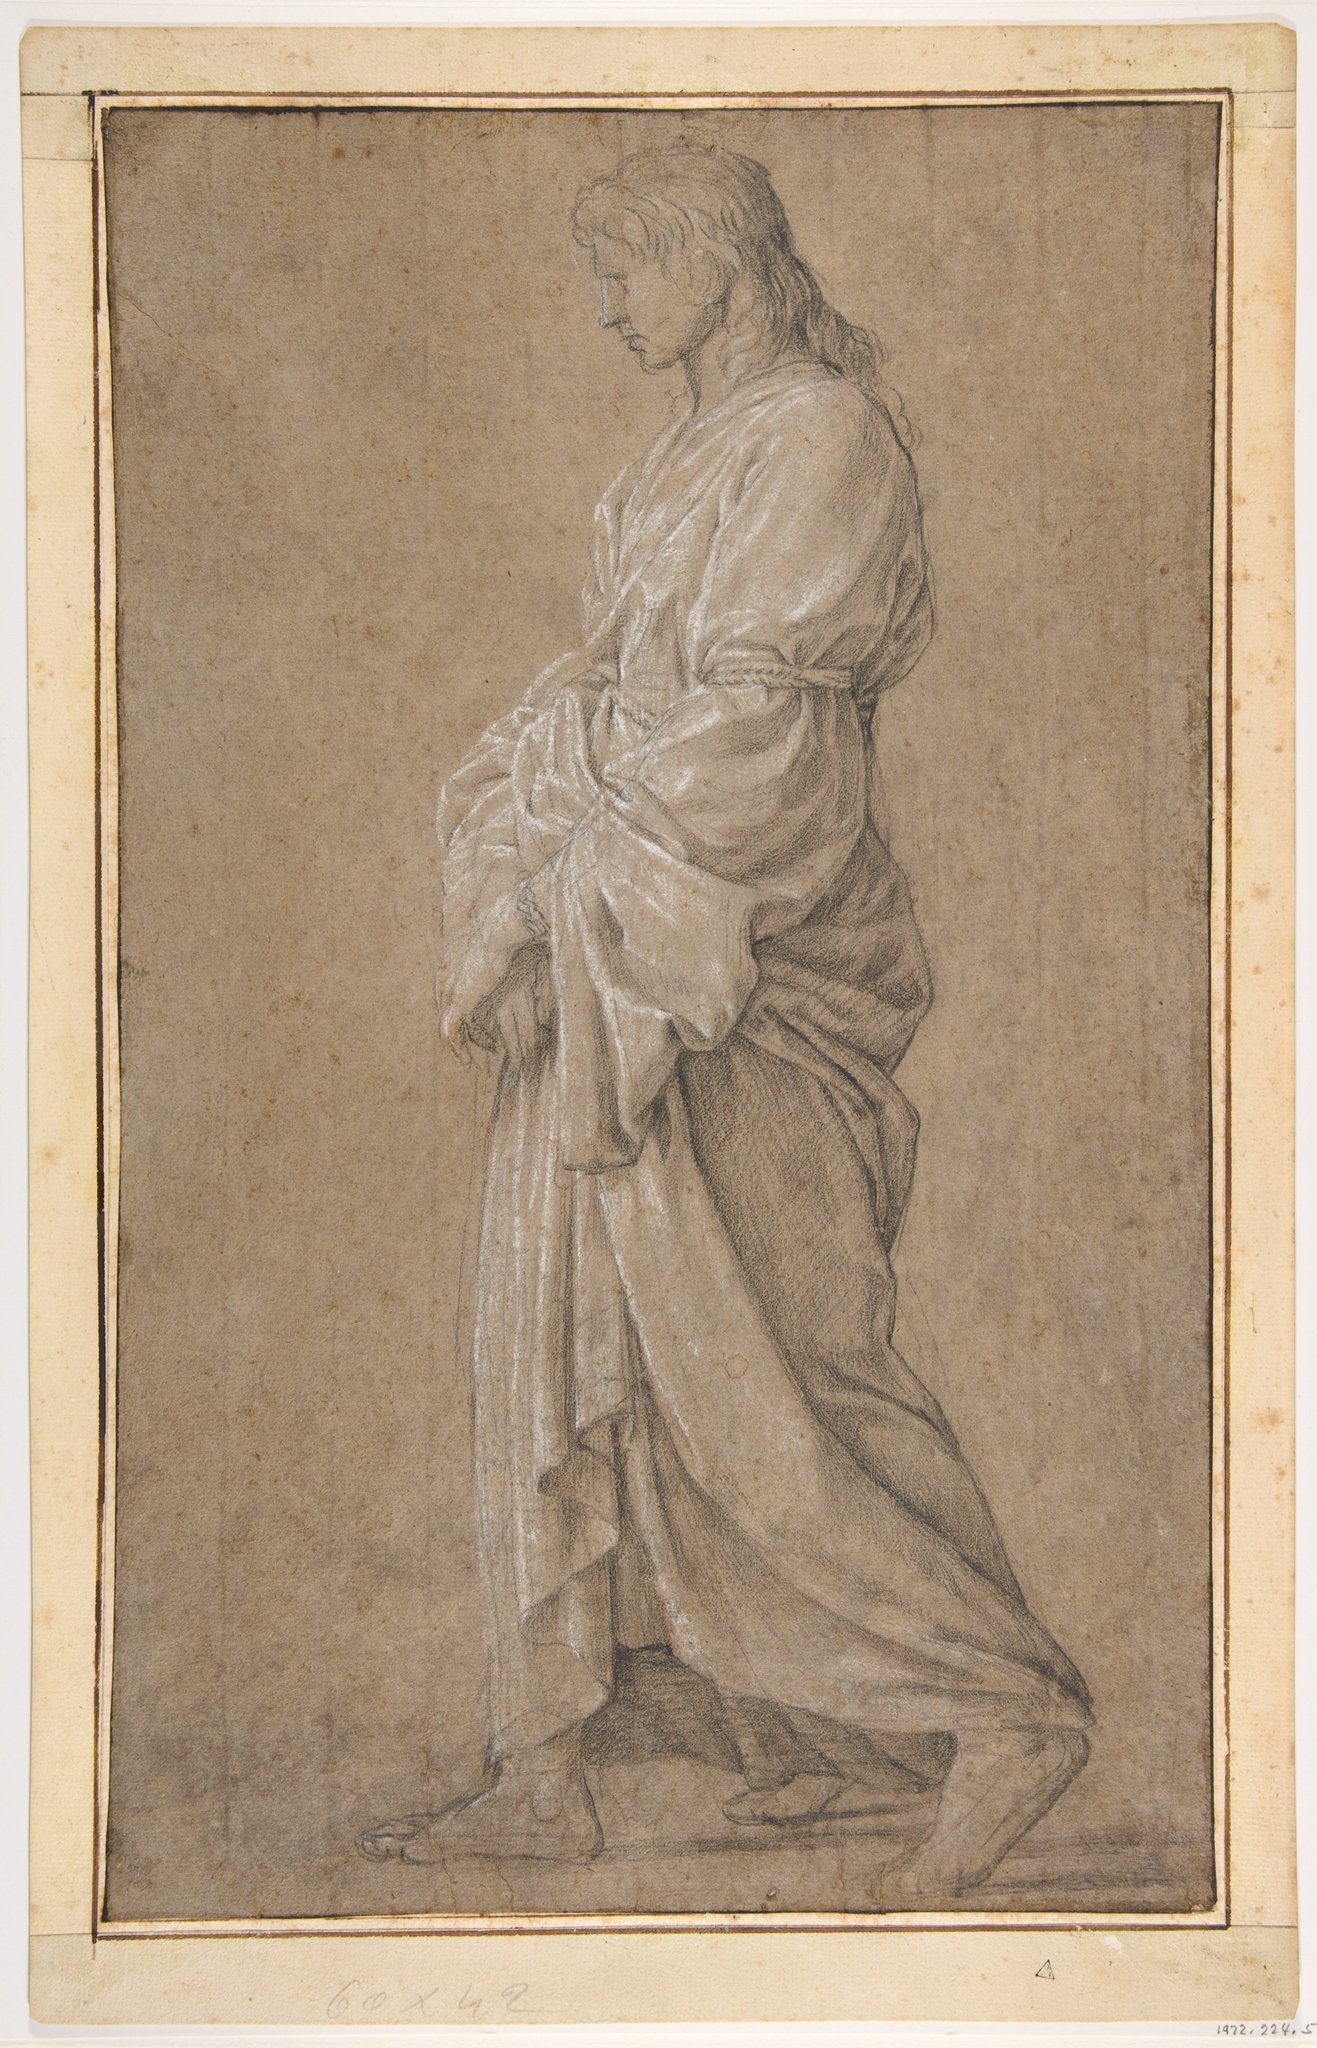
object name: drawing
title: Study for Saint Gervasius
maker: eustache le sueur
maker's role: artist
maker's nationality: french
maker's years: 1616-1655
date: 1652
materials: chalk, ink, paper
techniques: heightening, pen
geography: france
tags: saints